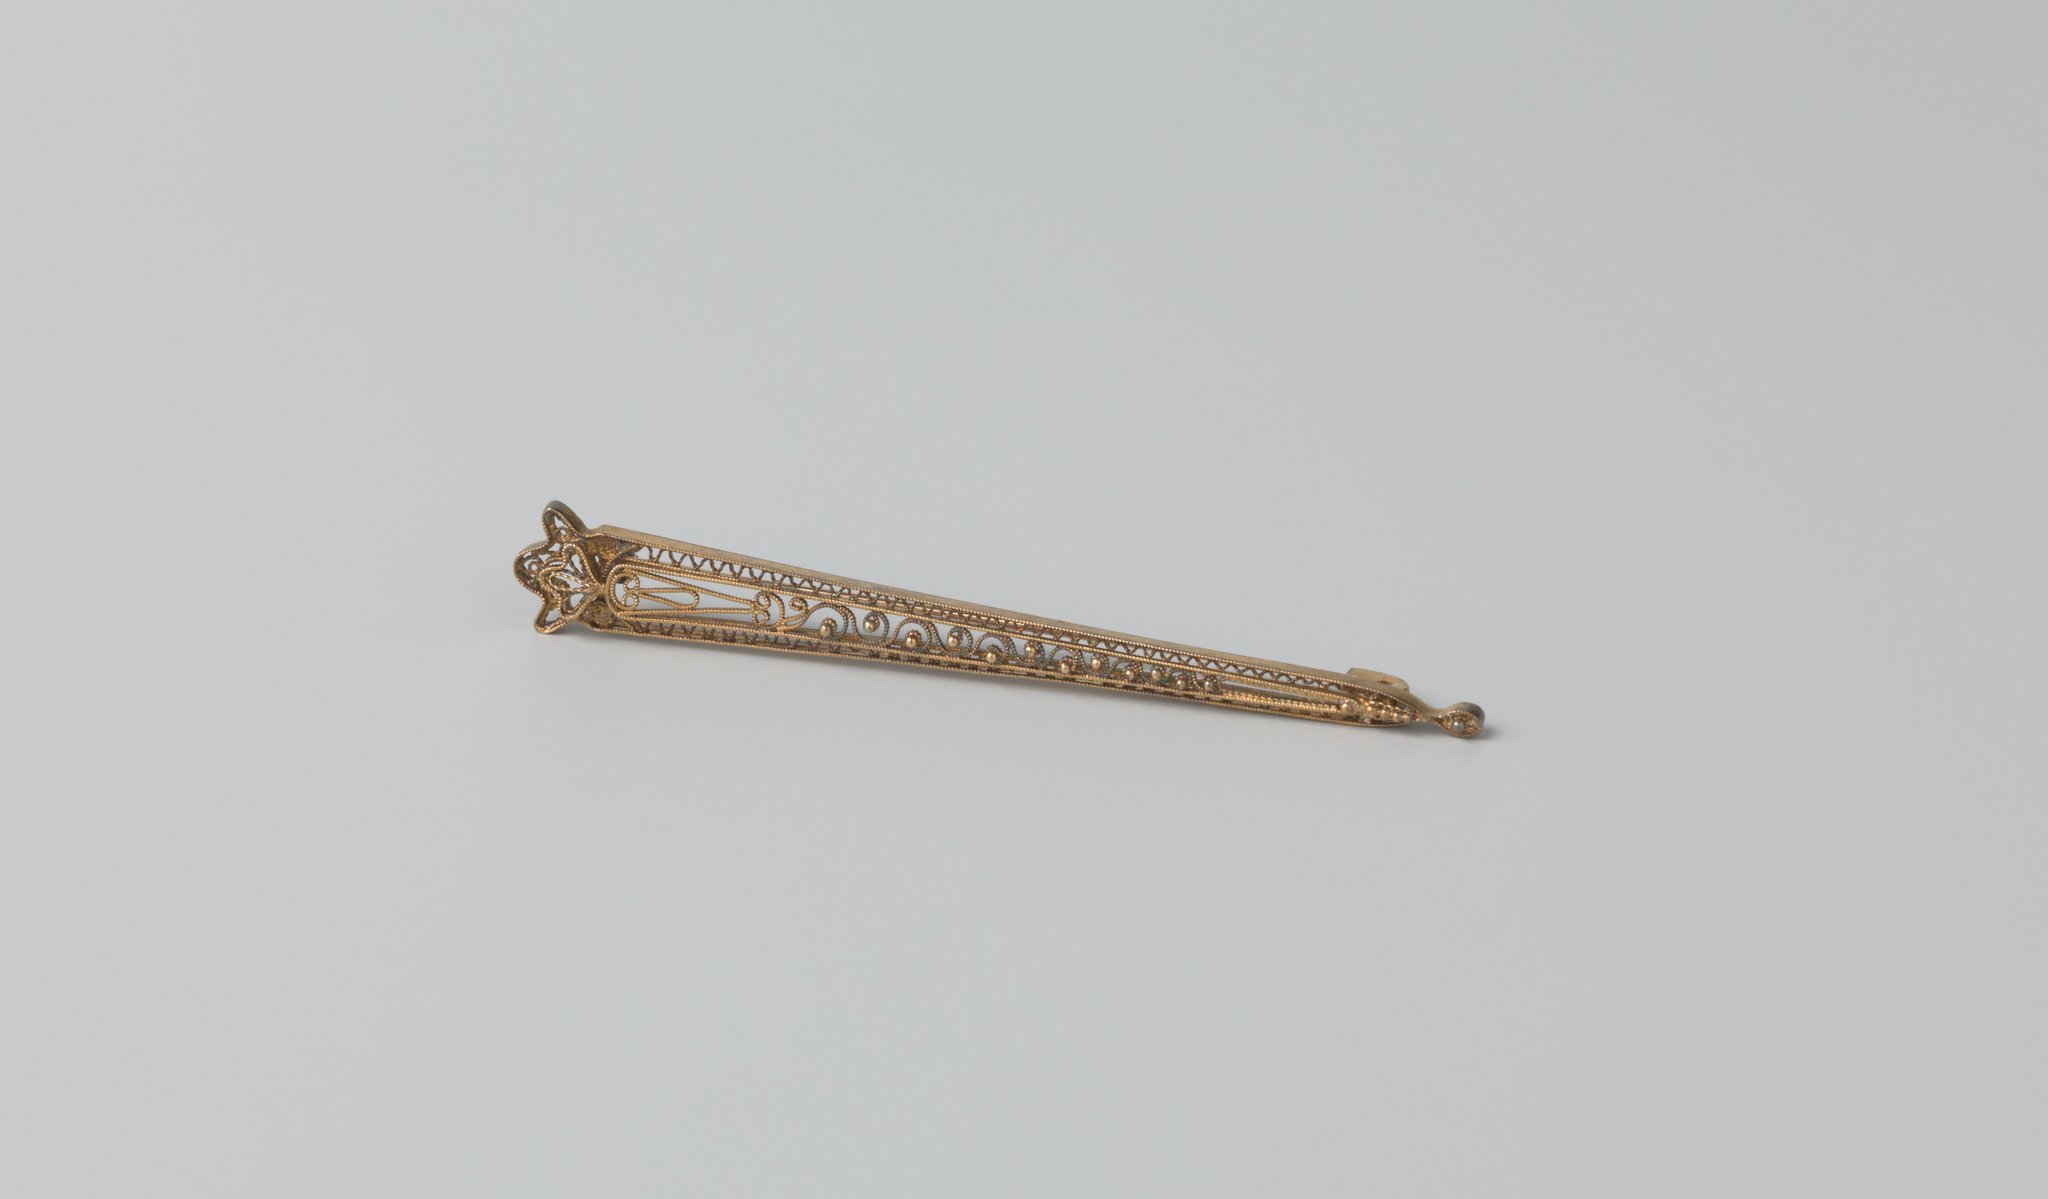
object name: doekspeld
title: Jabotspeld van goudfiligrein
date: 1900-1910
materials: gold, gold thread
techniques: filigree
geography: netherlands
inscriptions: maker's mark: ‘GR’, alloy mark: ‘oud eikenblad’